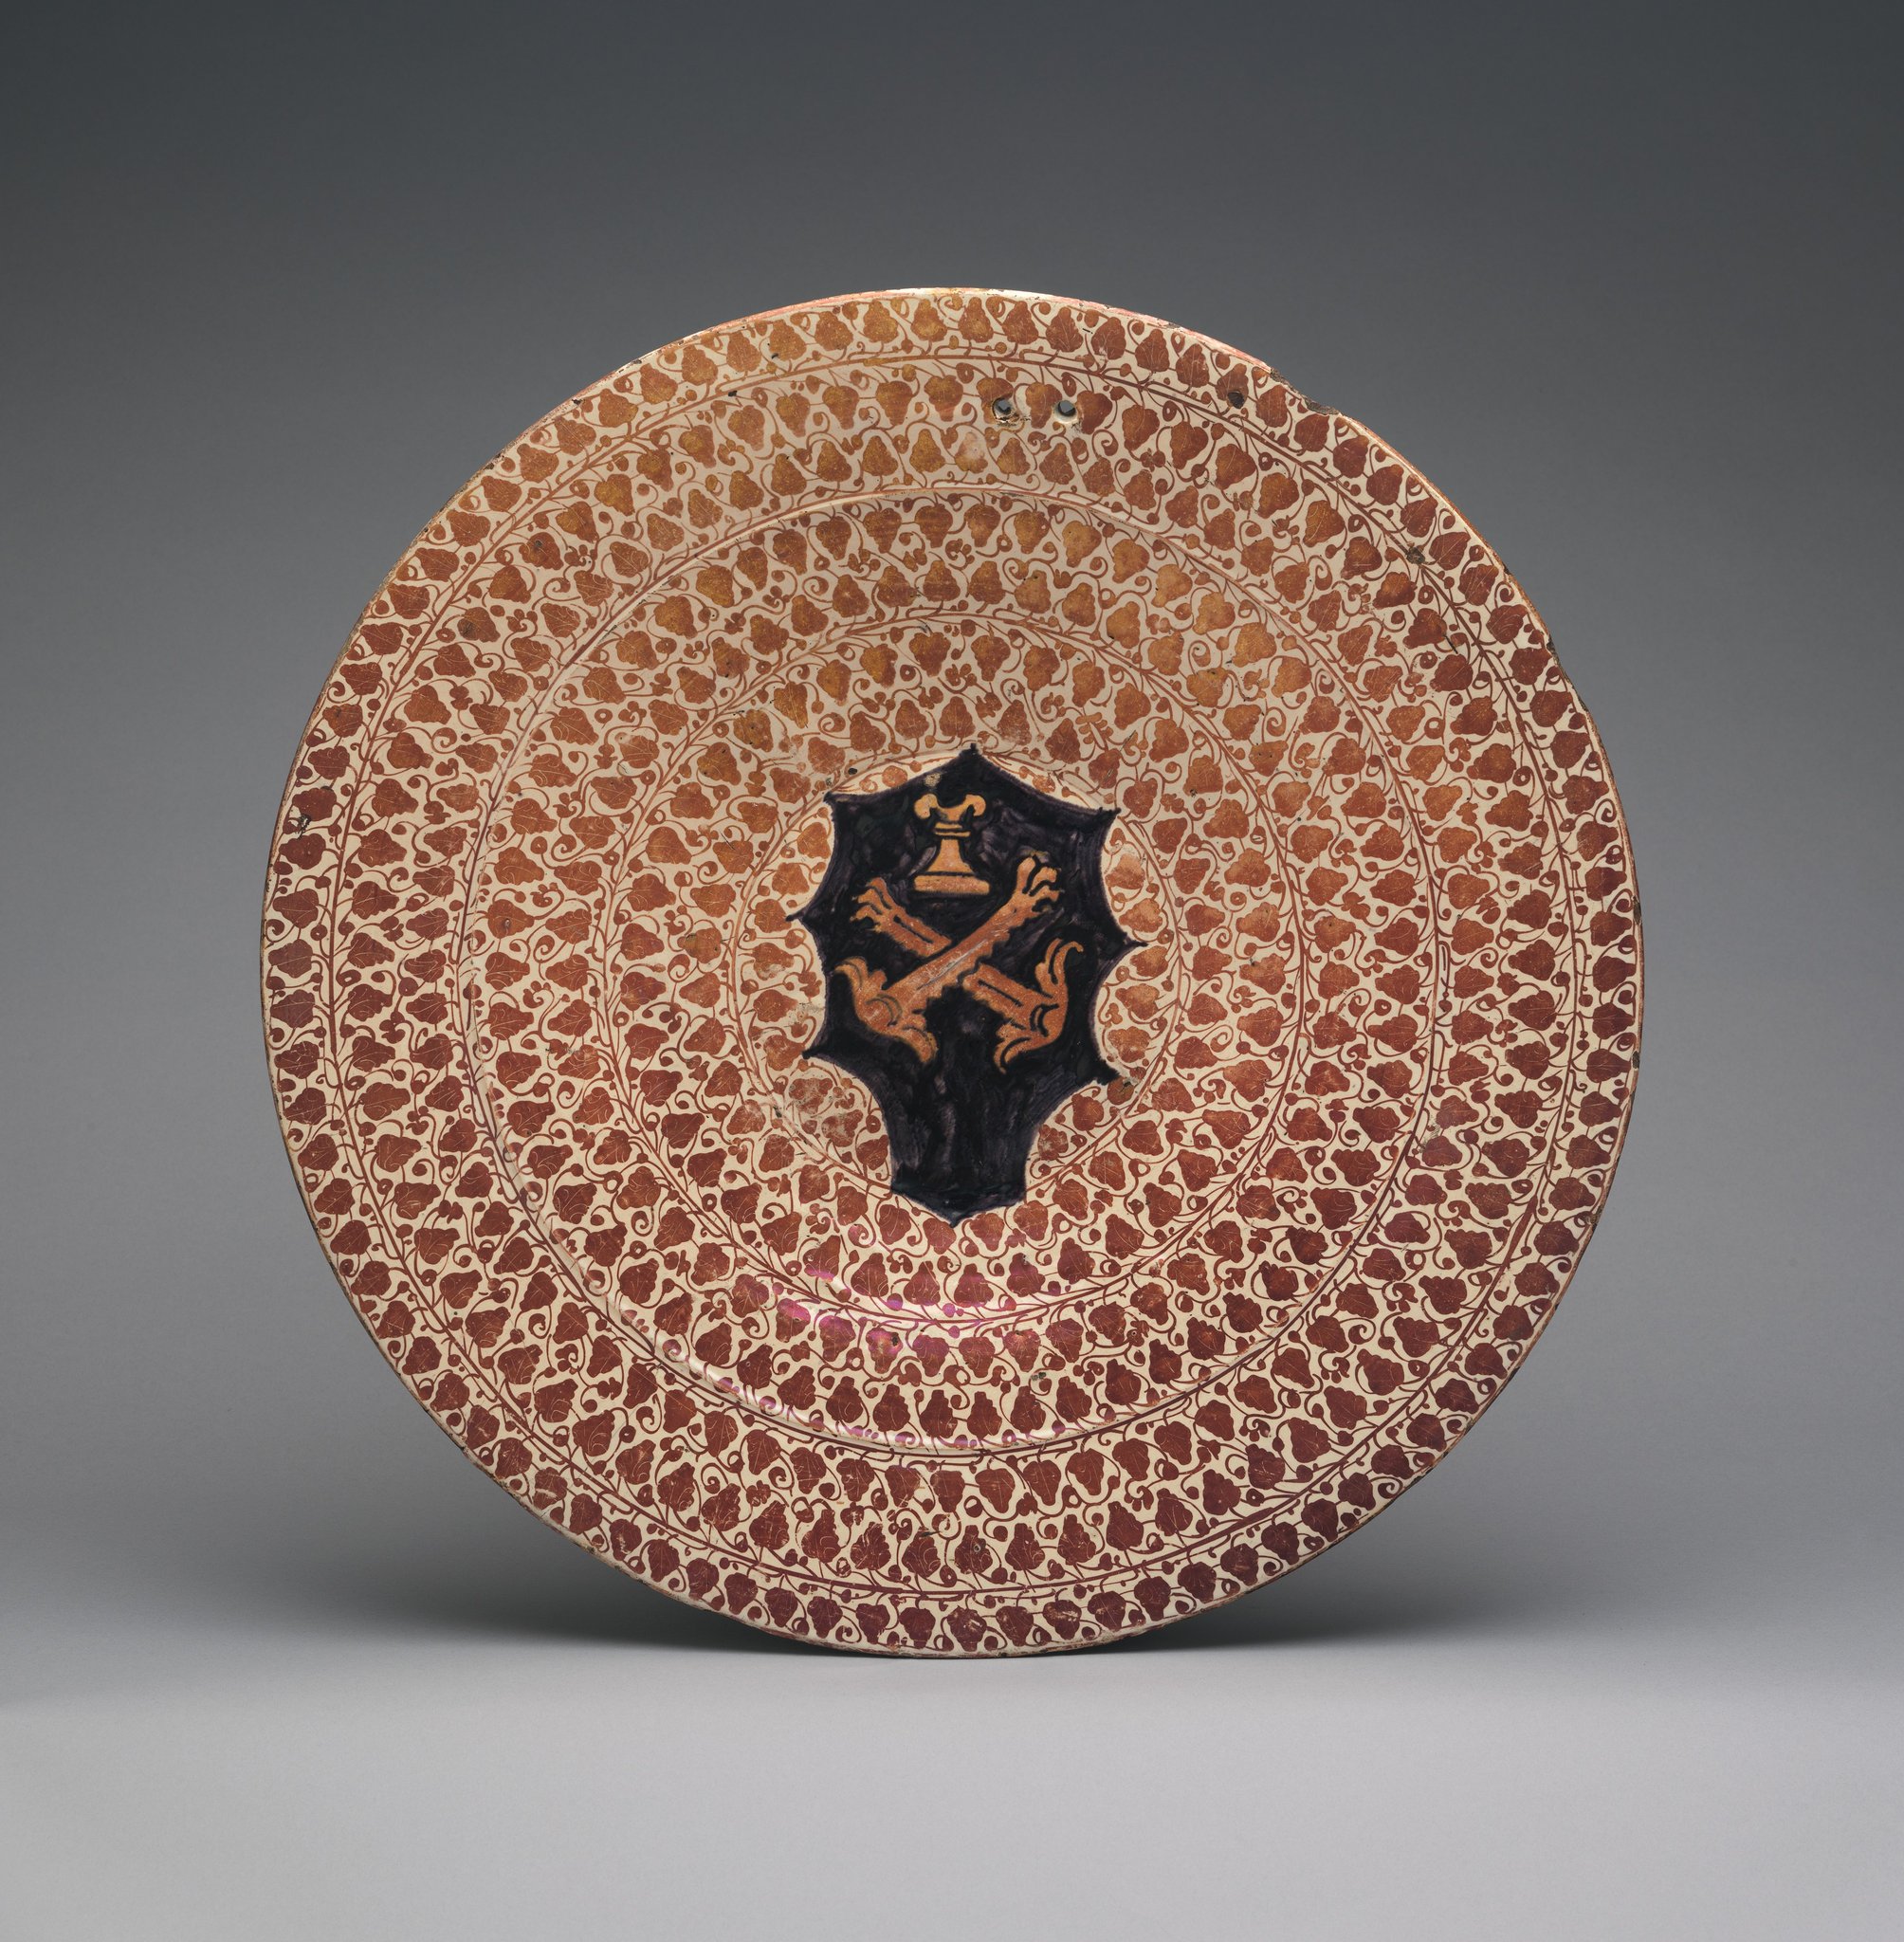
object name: plate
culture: spanish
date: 1430-1470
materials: earthenware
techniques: glazing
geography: spain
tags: insignia